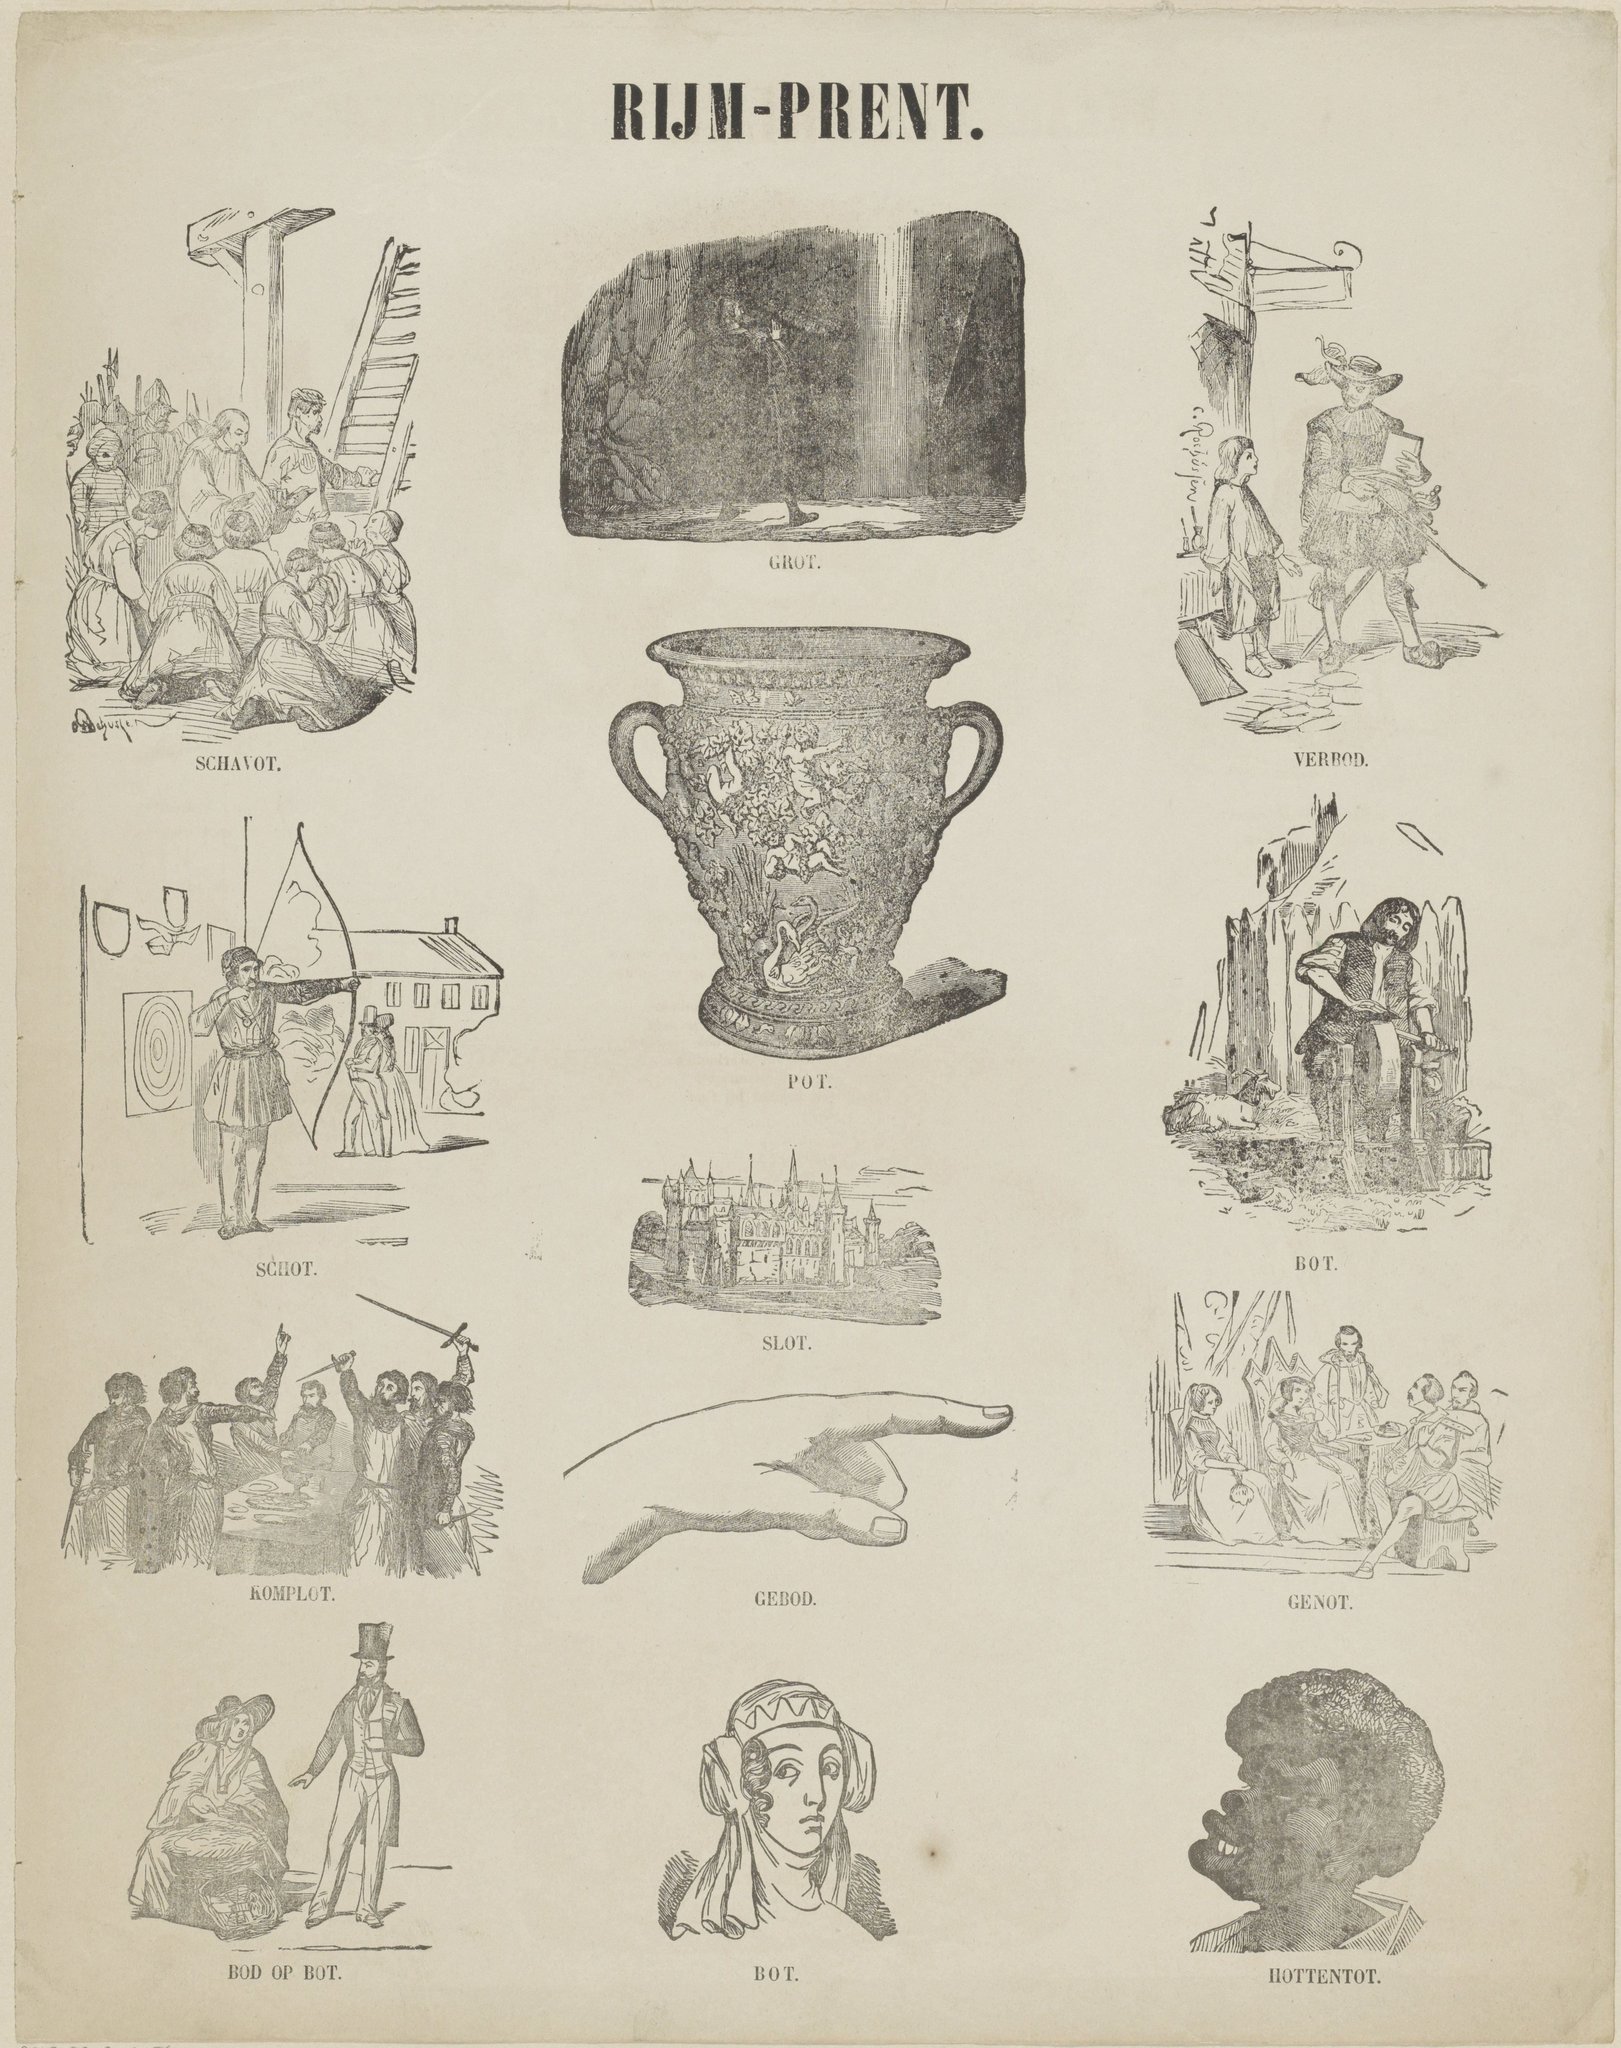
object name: print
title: Rijm-prent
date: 1861-1929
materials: paper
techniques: letterpress printing, engraving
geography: leiden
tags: human types, letters, alphabet, script, characters (human types), cave, grotto, on the scaffold or place of execution, khoikhoi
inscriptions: collector's mark: Lugt 2760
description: Blad met 13 voorstellingen van verschillende aard waarvan de woorden rijmen, zoals schavot, grot en verbod. Onder elke voorstelling een onderschrift in boekdruk.